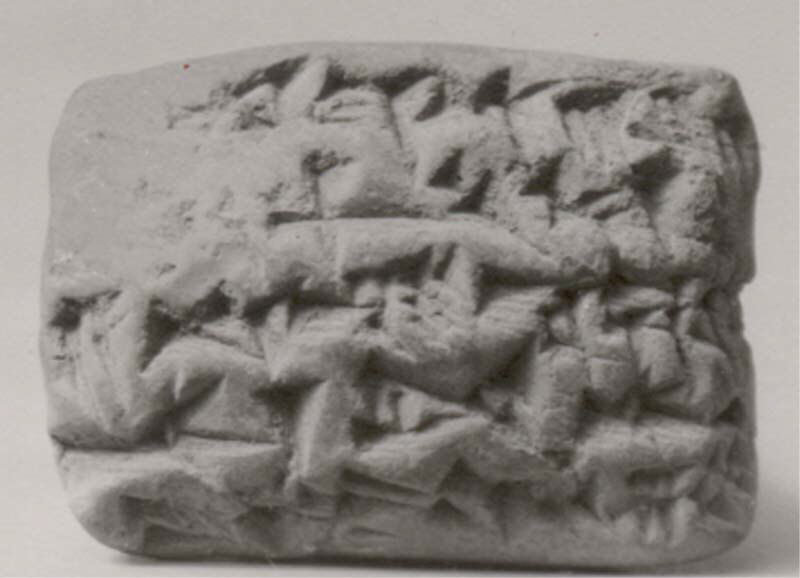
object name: cuneiform tablet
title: Cuneiform tablet: receipt of silver for a wash-bowl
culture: babylonian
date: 700-501 BCE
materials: clay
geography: mesopotamia